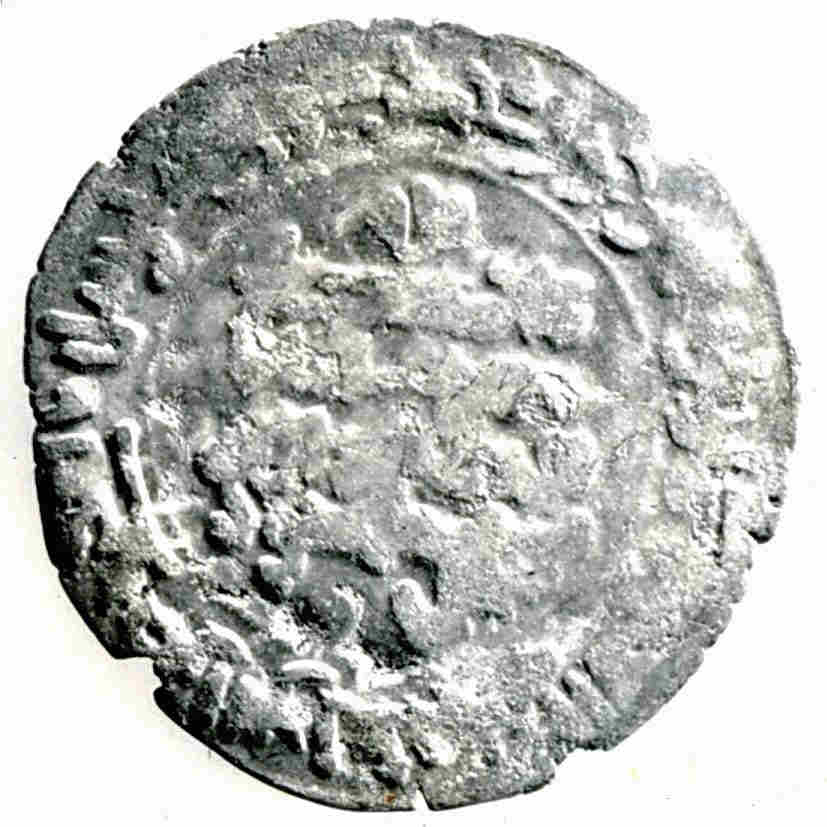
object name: coin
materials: silver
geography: al-shash